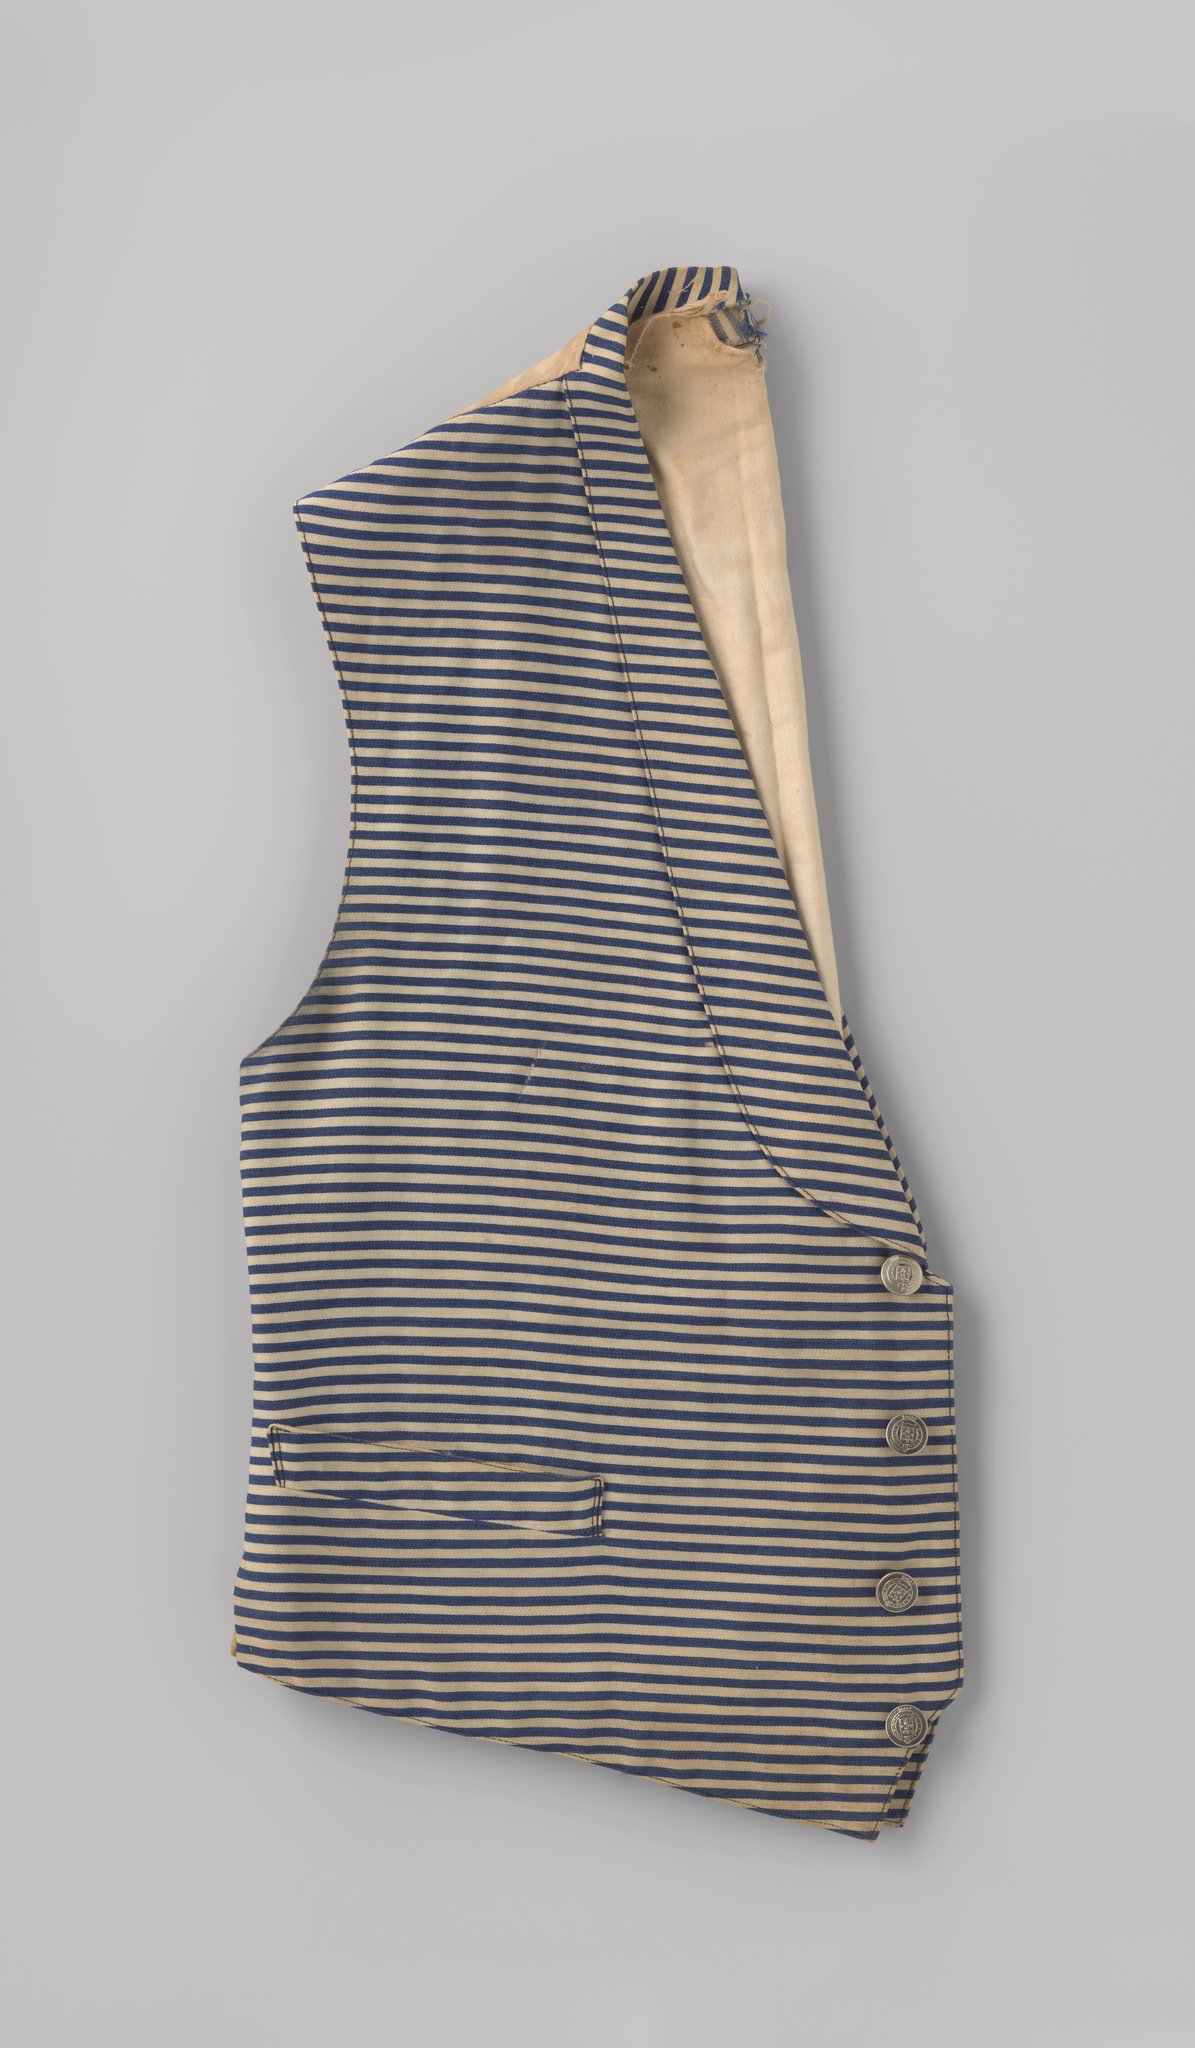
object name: main garment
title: Vest met drie steekzakken en sjaalkraag van blauwwit horizontaal gestreept katoen, met vier metalen knopen met een fleur de lys en het devies "hora ruit"; rugpand van wit katoen.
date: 1913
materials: cotton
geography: the hague